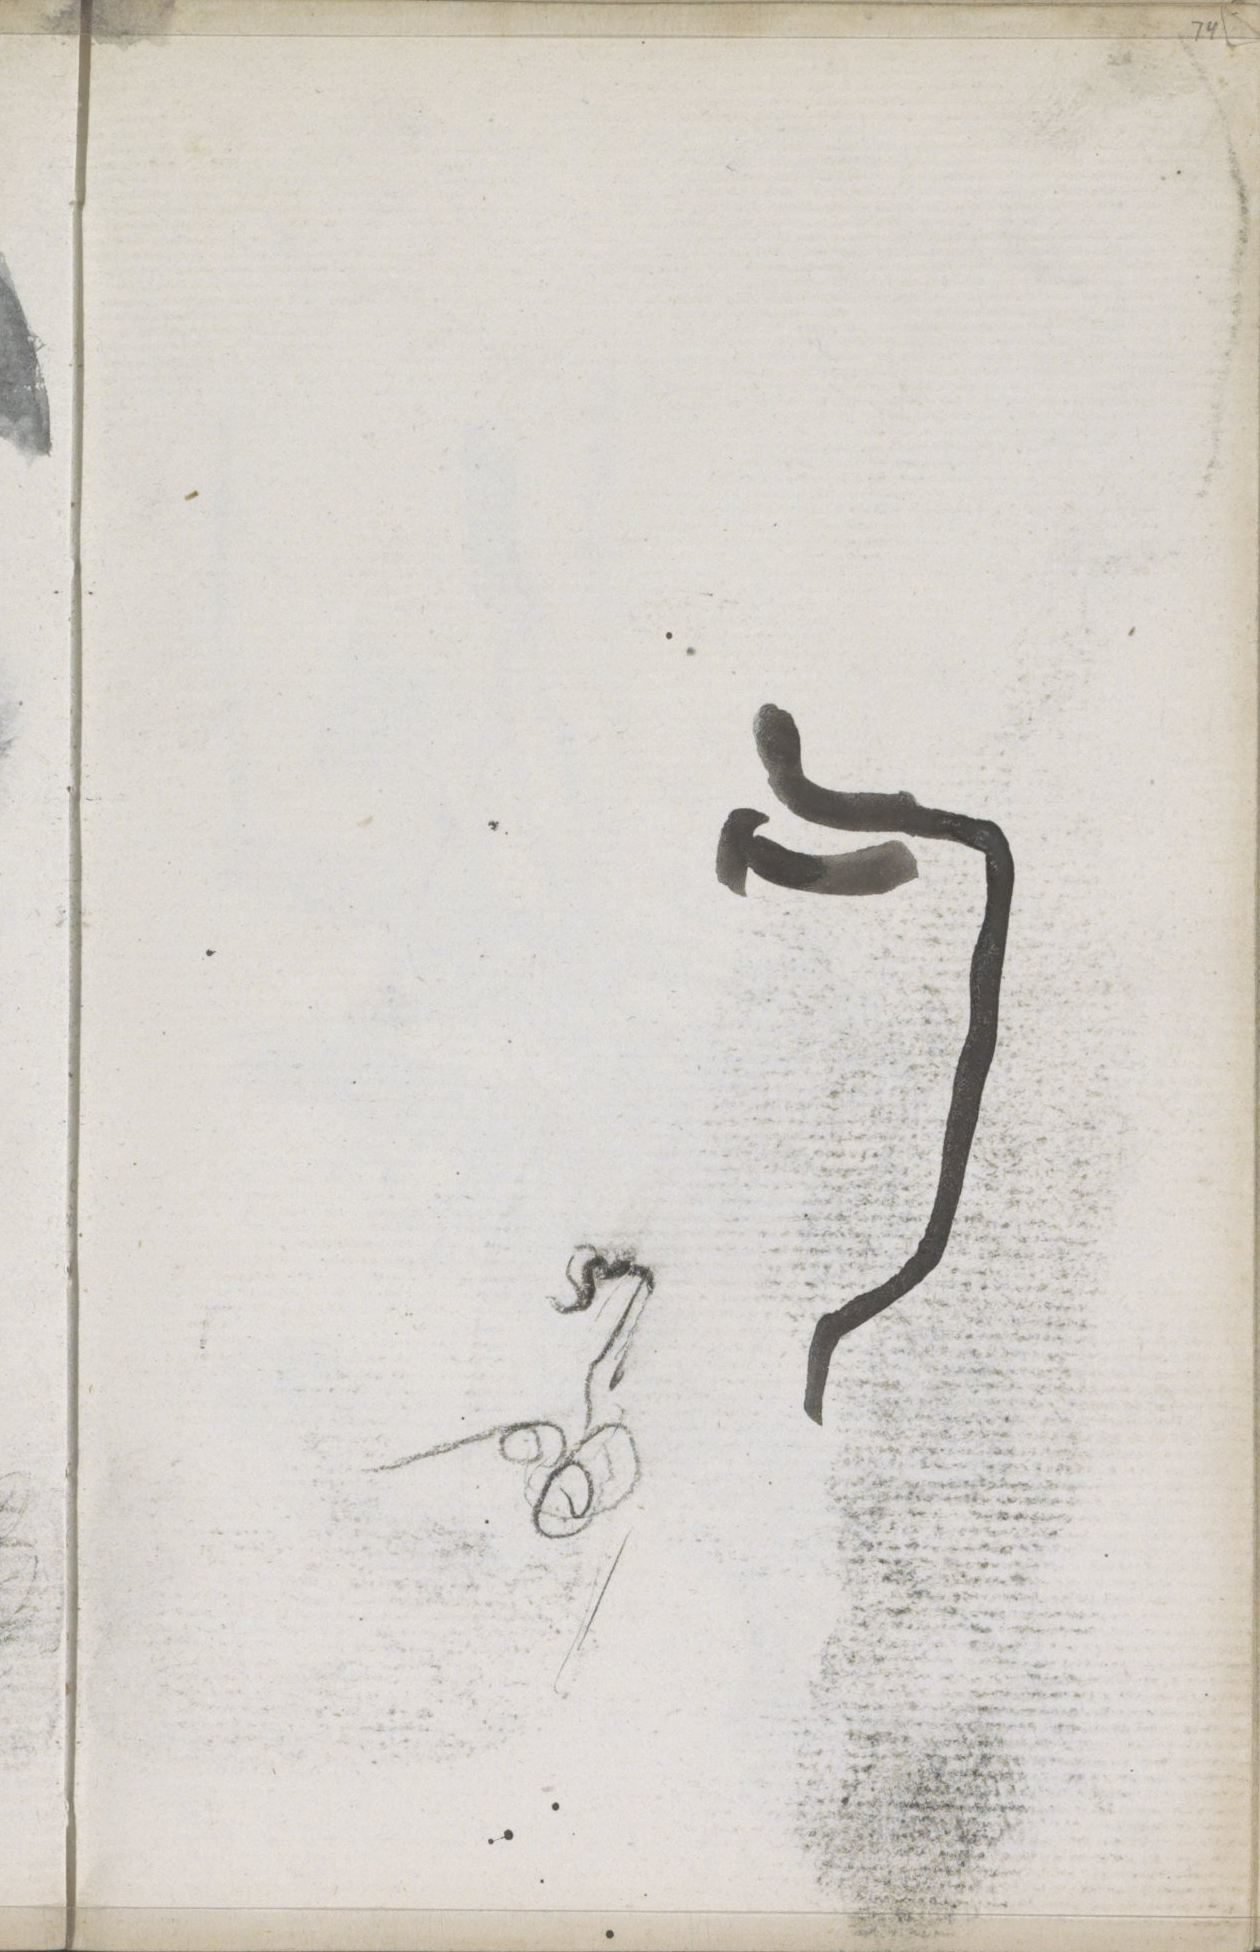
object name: sketchbook leaf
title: Twee neuzen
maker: george hendrik breitner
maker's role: draughtsman, painter, print maker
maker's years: 1857-1923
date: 1884-1886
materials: chalk, paper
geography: drenthe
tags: parts of the face: nose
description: Pagina 74 uit een schetsboek met 67 bladen vervaardigd in Drenthe.